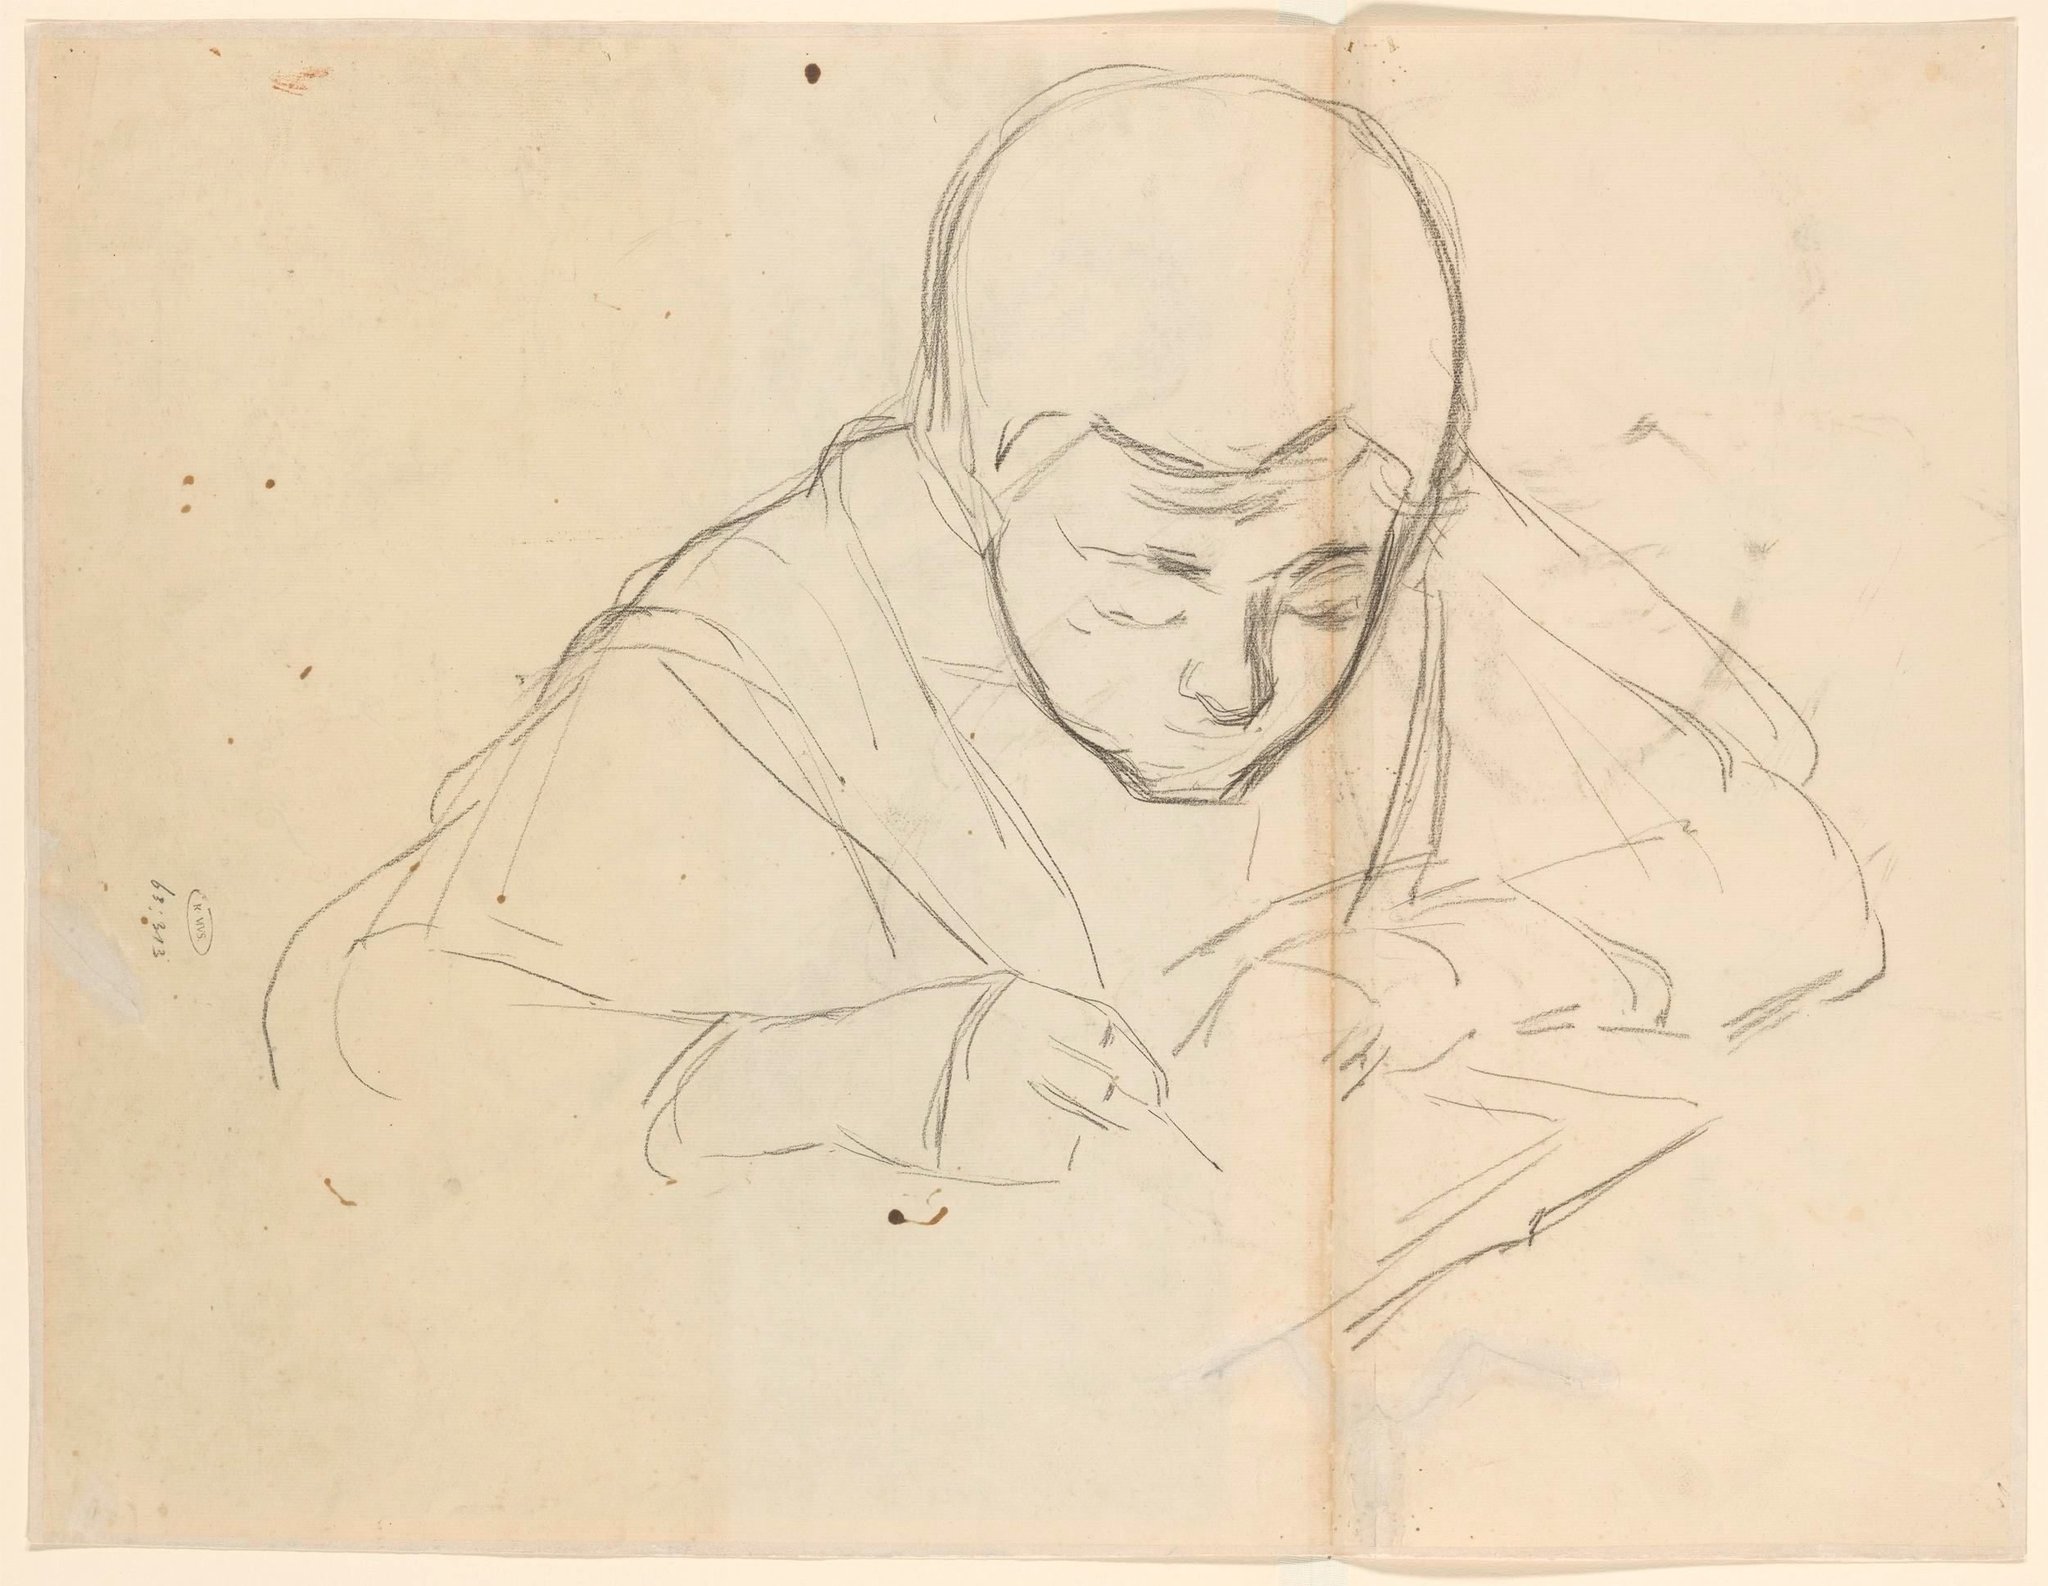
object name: drawing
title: Schrijvende jongen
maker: ferdinand oldewelt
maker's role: draughtsman, print maker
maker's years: 1857-1935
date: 1809-1891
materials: chalk, paper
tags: handwriting, writing as activity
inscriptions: date